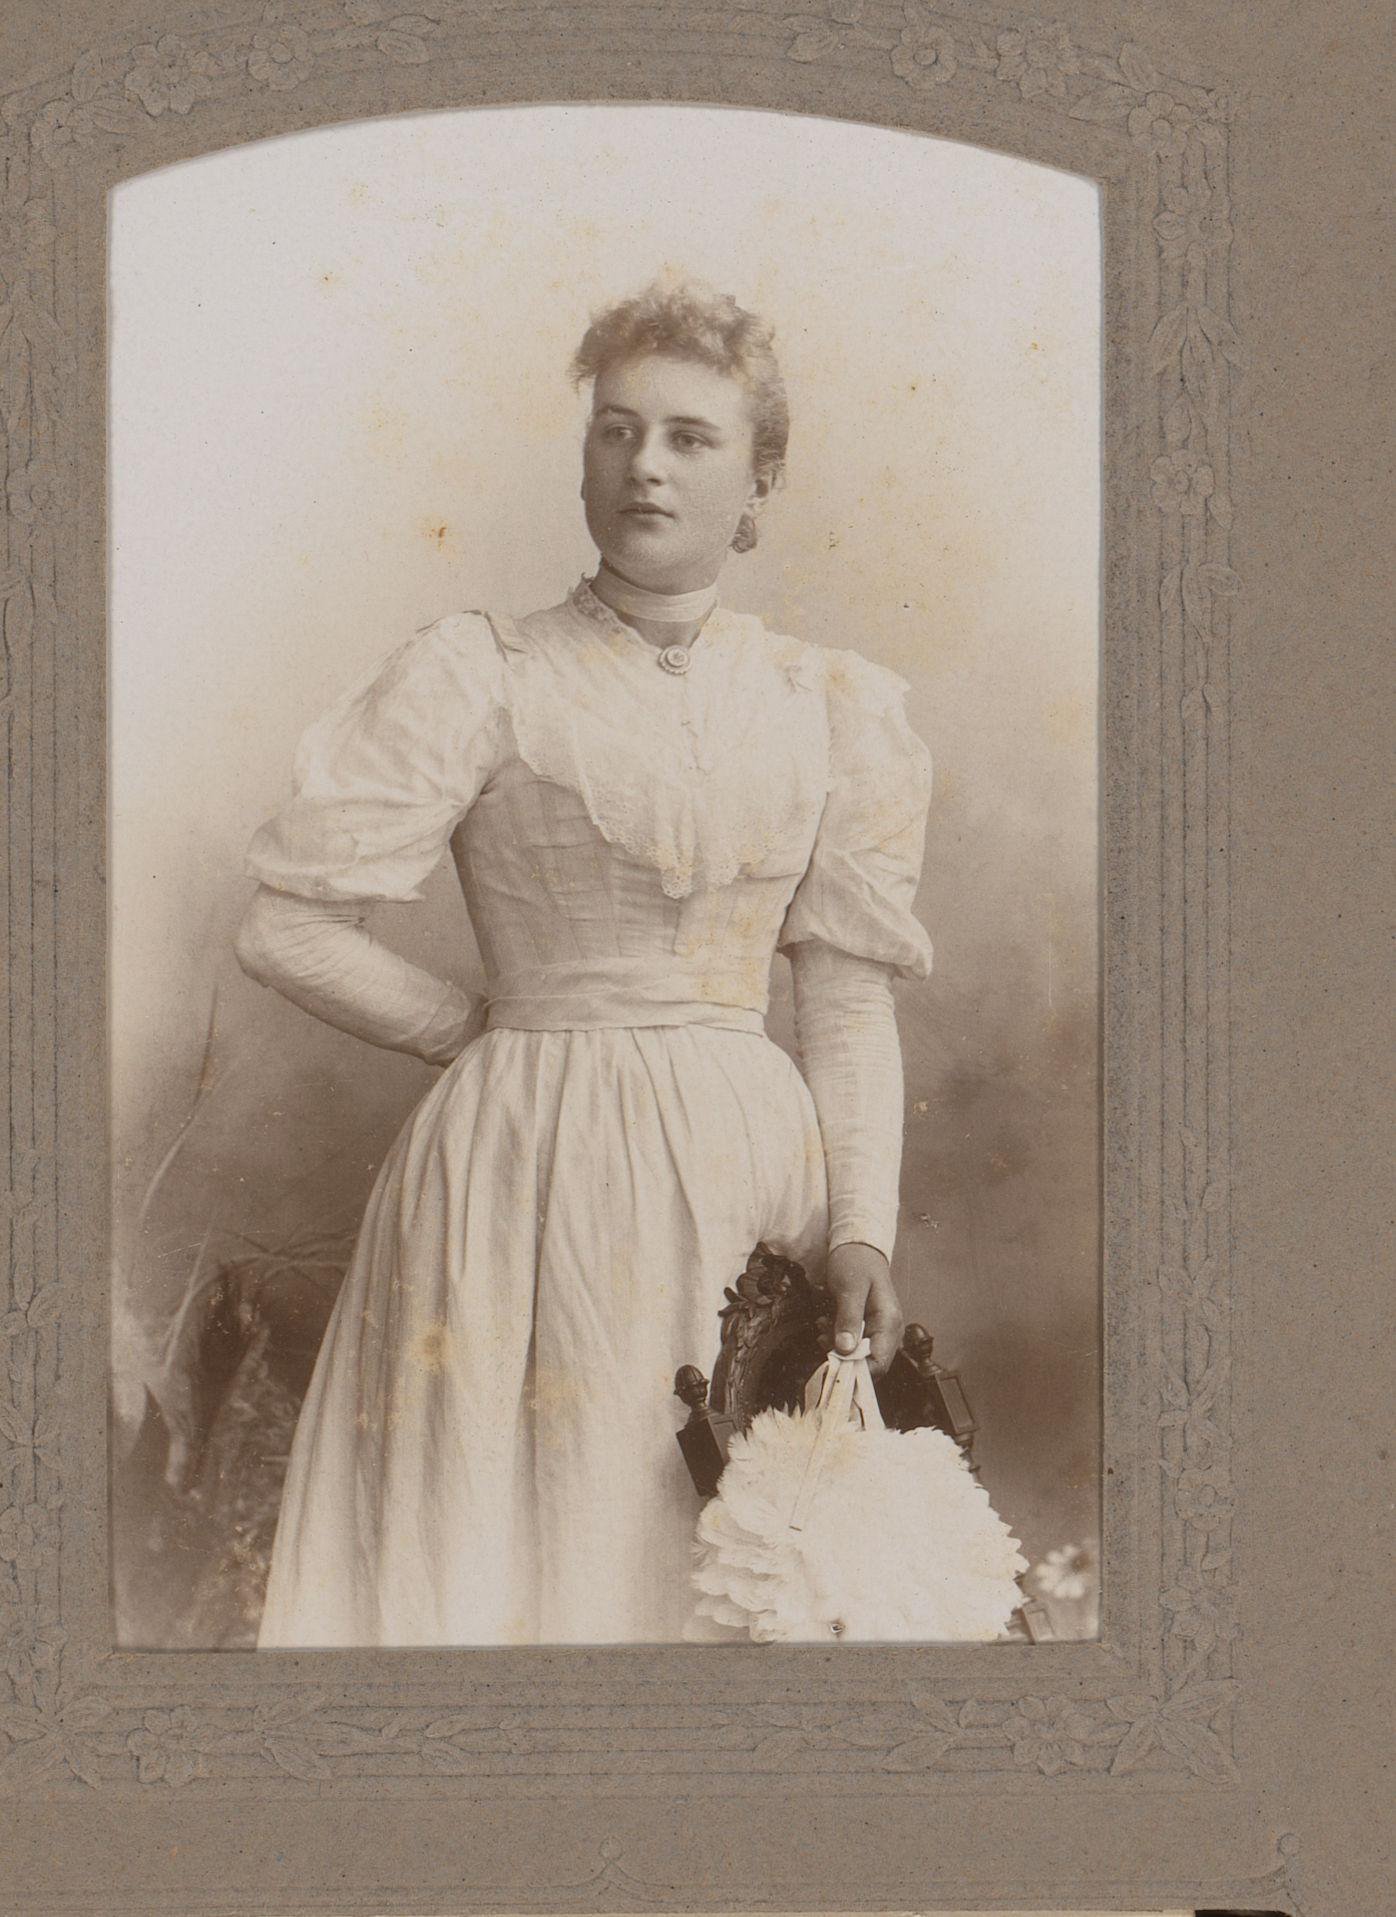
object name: photograph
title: Portret van een jonge vrouw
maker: cornelis johannes lodewicus vermeulen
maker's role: fotograaf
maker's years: 1861-1936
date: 1878-1898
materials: cardboard, photographic support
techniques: collodion silver print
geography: amsterdam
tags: adolescent, young woman, maiden, historical persons - bb - woman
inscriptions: inscription: ‘Photographische/ Ateliers/ C. J. L. Vermeulen/ Heerenstraat 6,/ Heiligenweg/ hoek Singel/ Amsterdam./ Specialiteit in vergrootingen.’